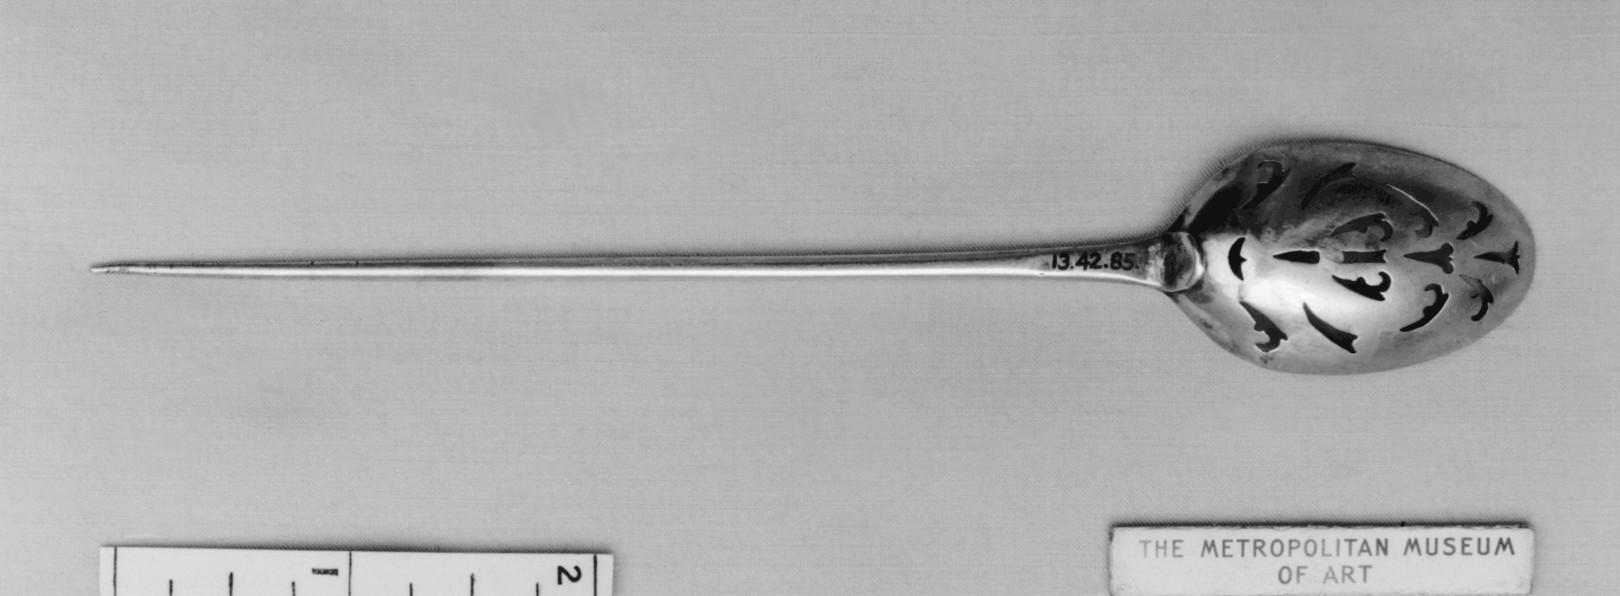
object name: strainer spoon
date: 1701-1800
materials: silver